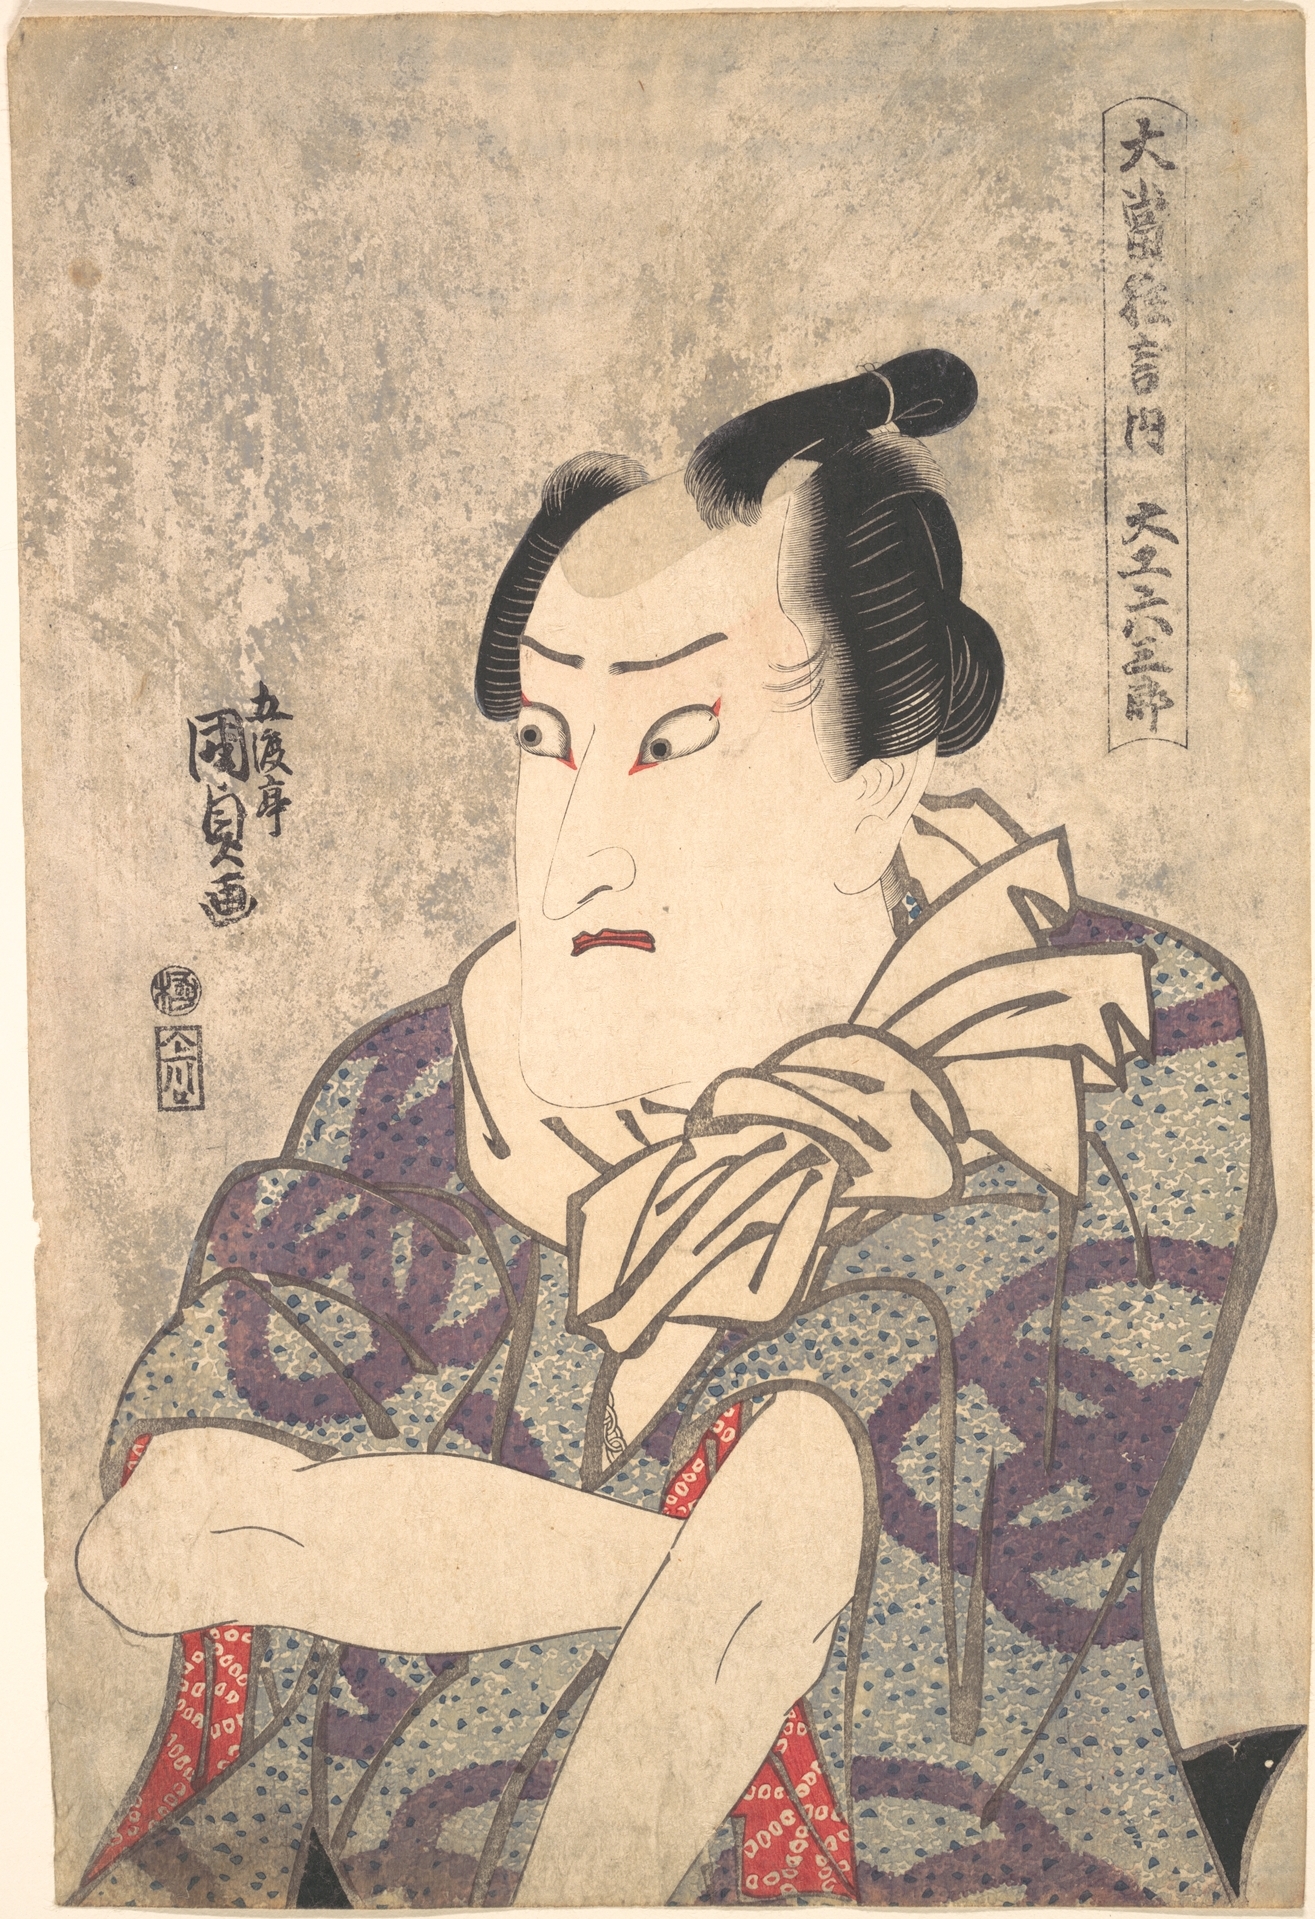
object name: print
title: Wild Words - a Play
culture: japanese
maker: utagawa kunisada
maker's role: artist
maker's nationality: japanese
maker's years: 1786-1864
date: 1786-1864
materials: ink, paper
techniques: woodblock print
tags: men,actors